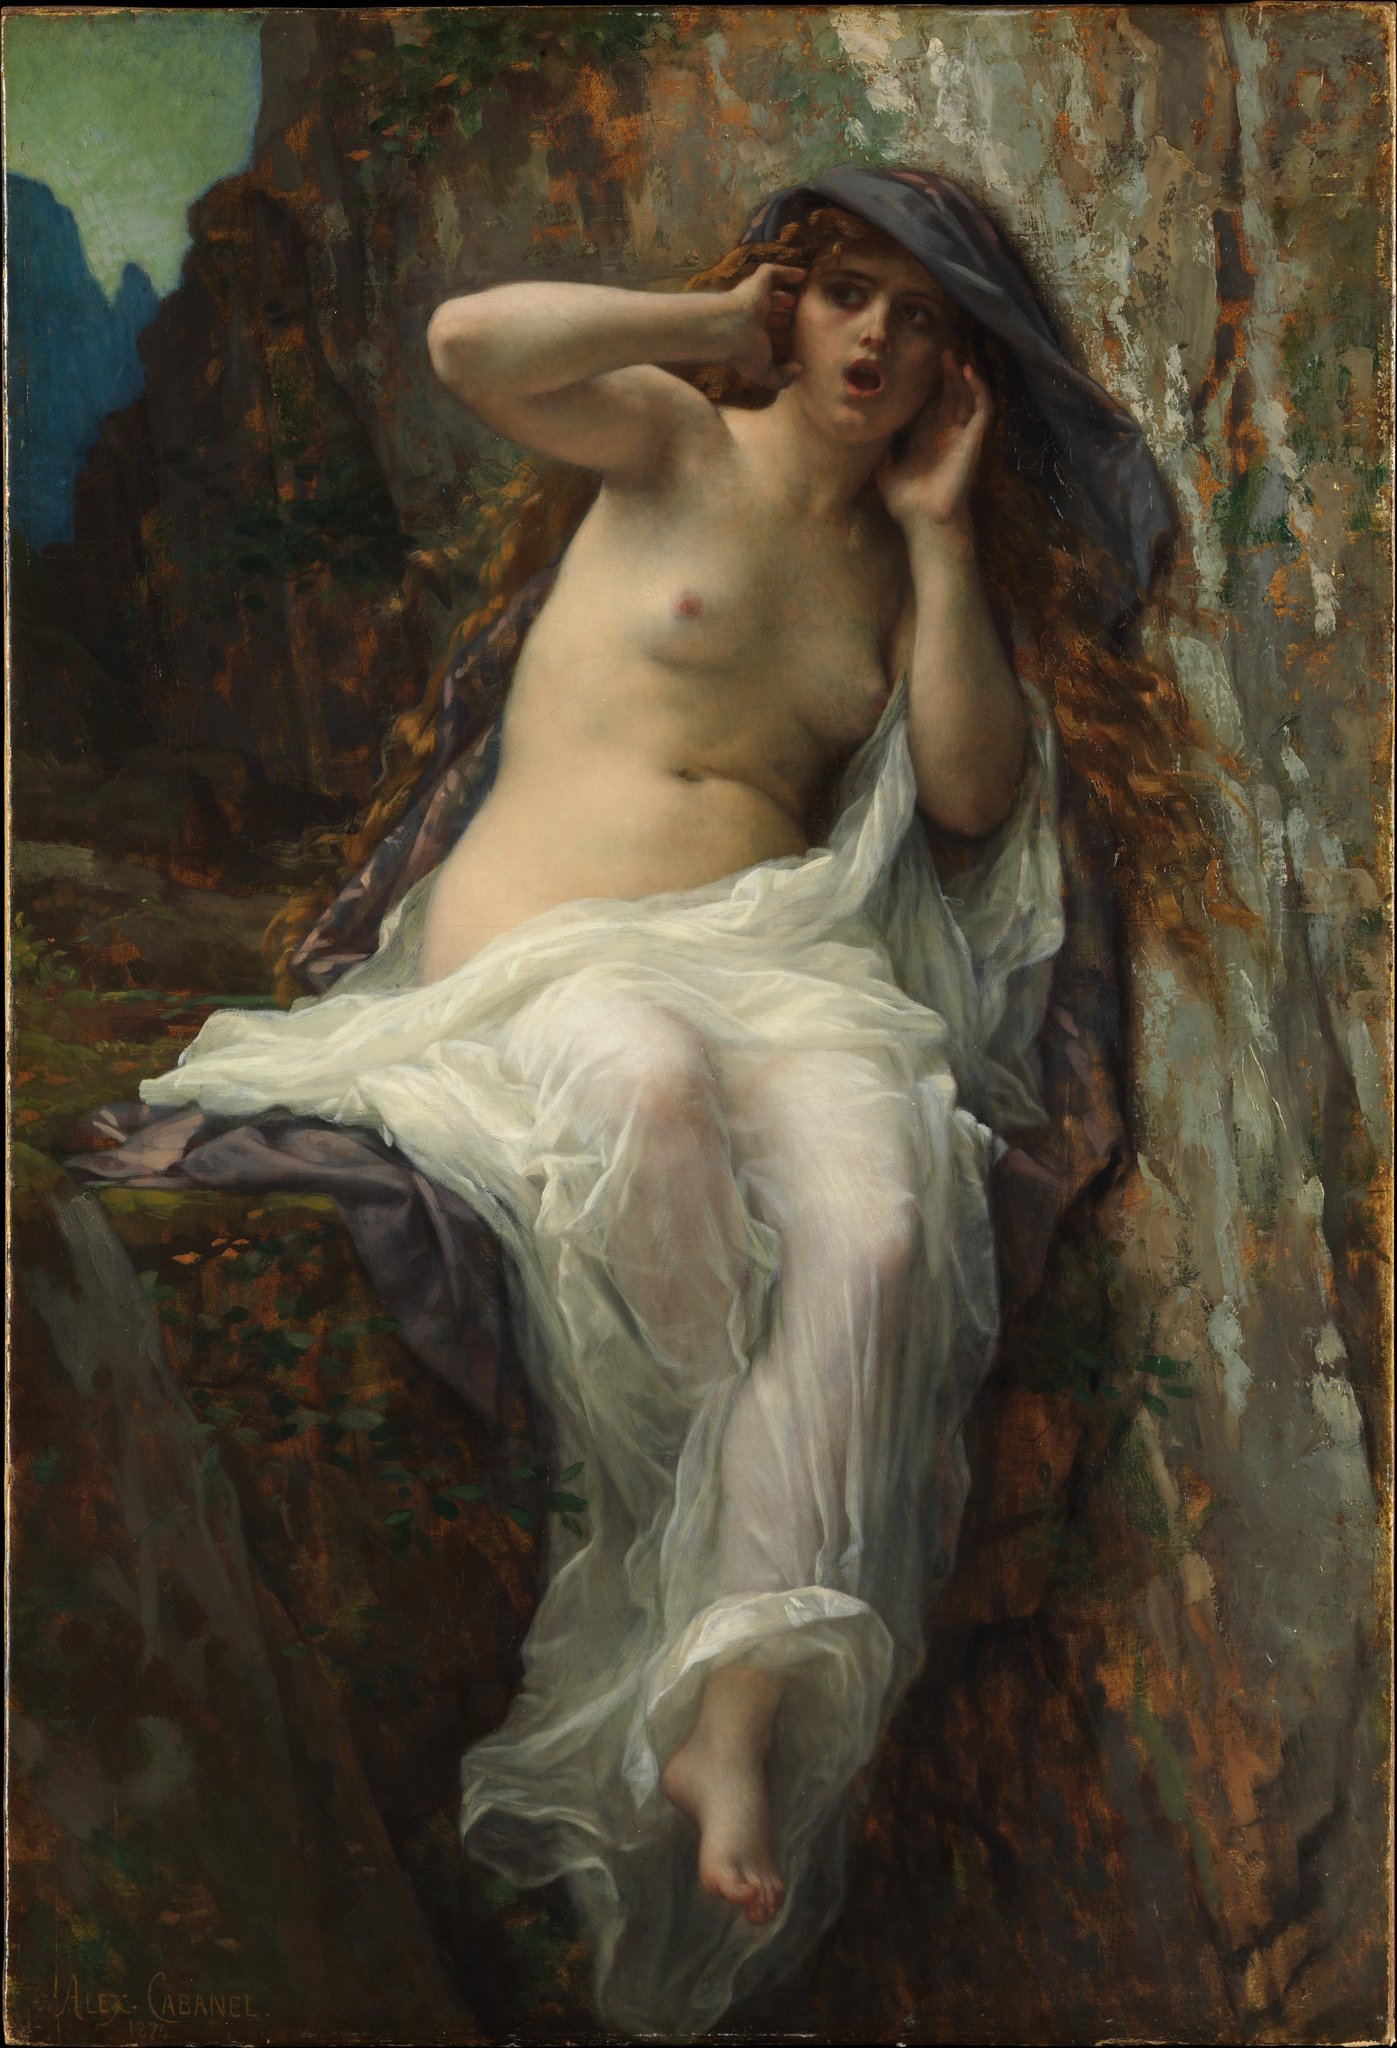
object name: painting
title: Echo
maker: alexandre cabanel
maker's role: artist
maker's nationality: french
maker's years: 1823-1889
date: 1874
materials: canvas, oil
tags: female nudes,nymphs